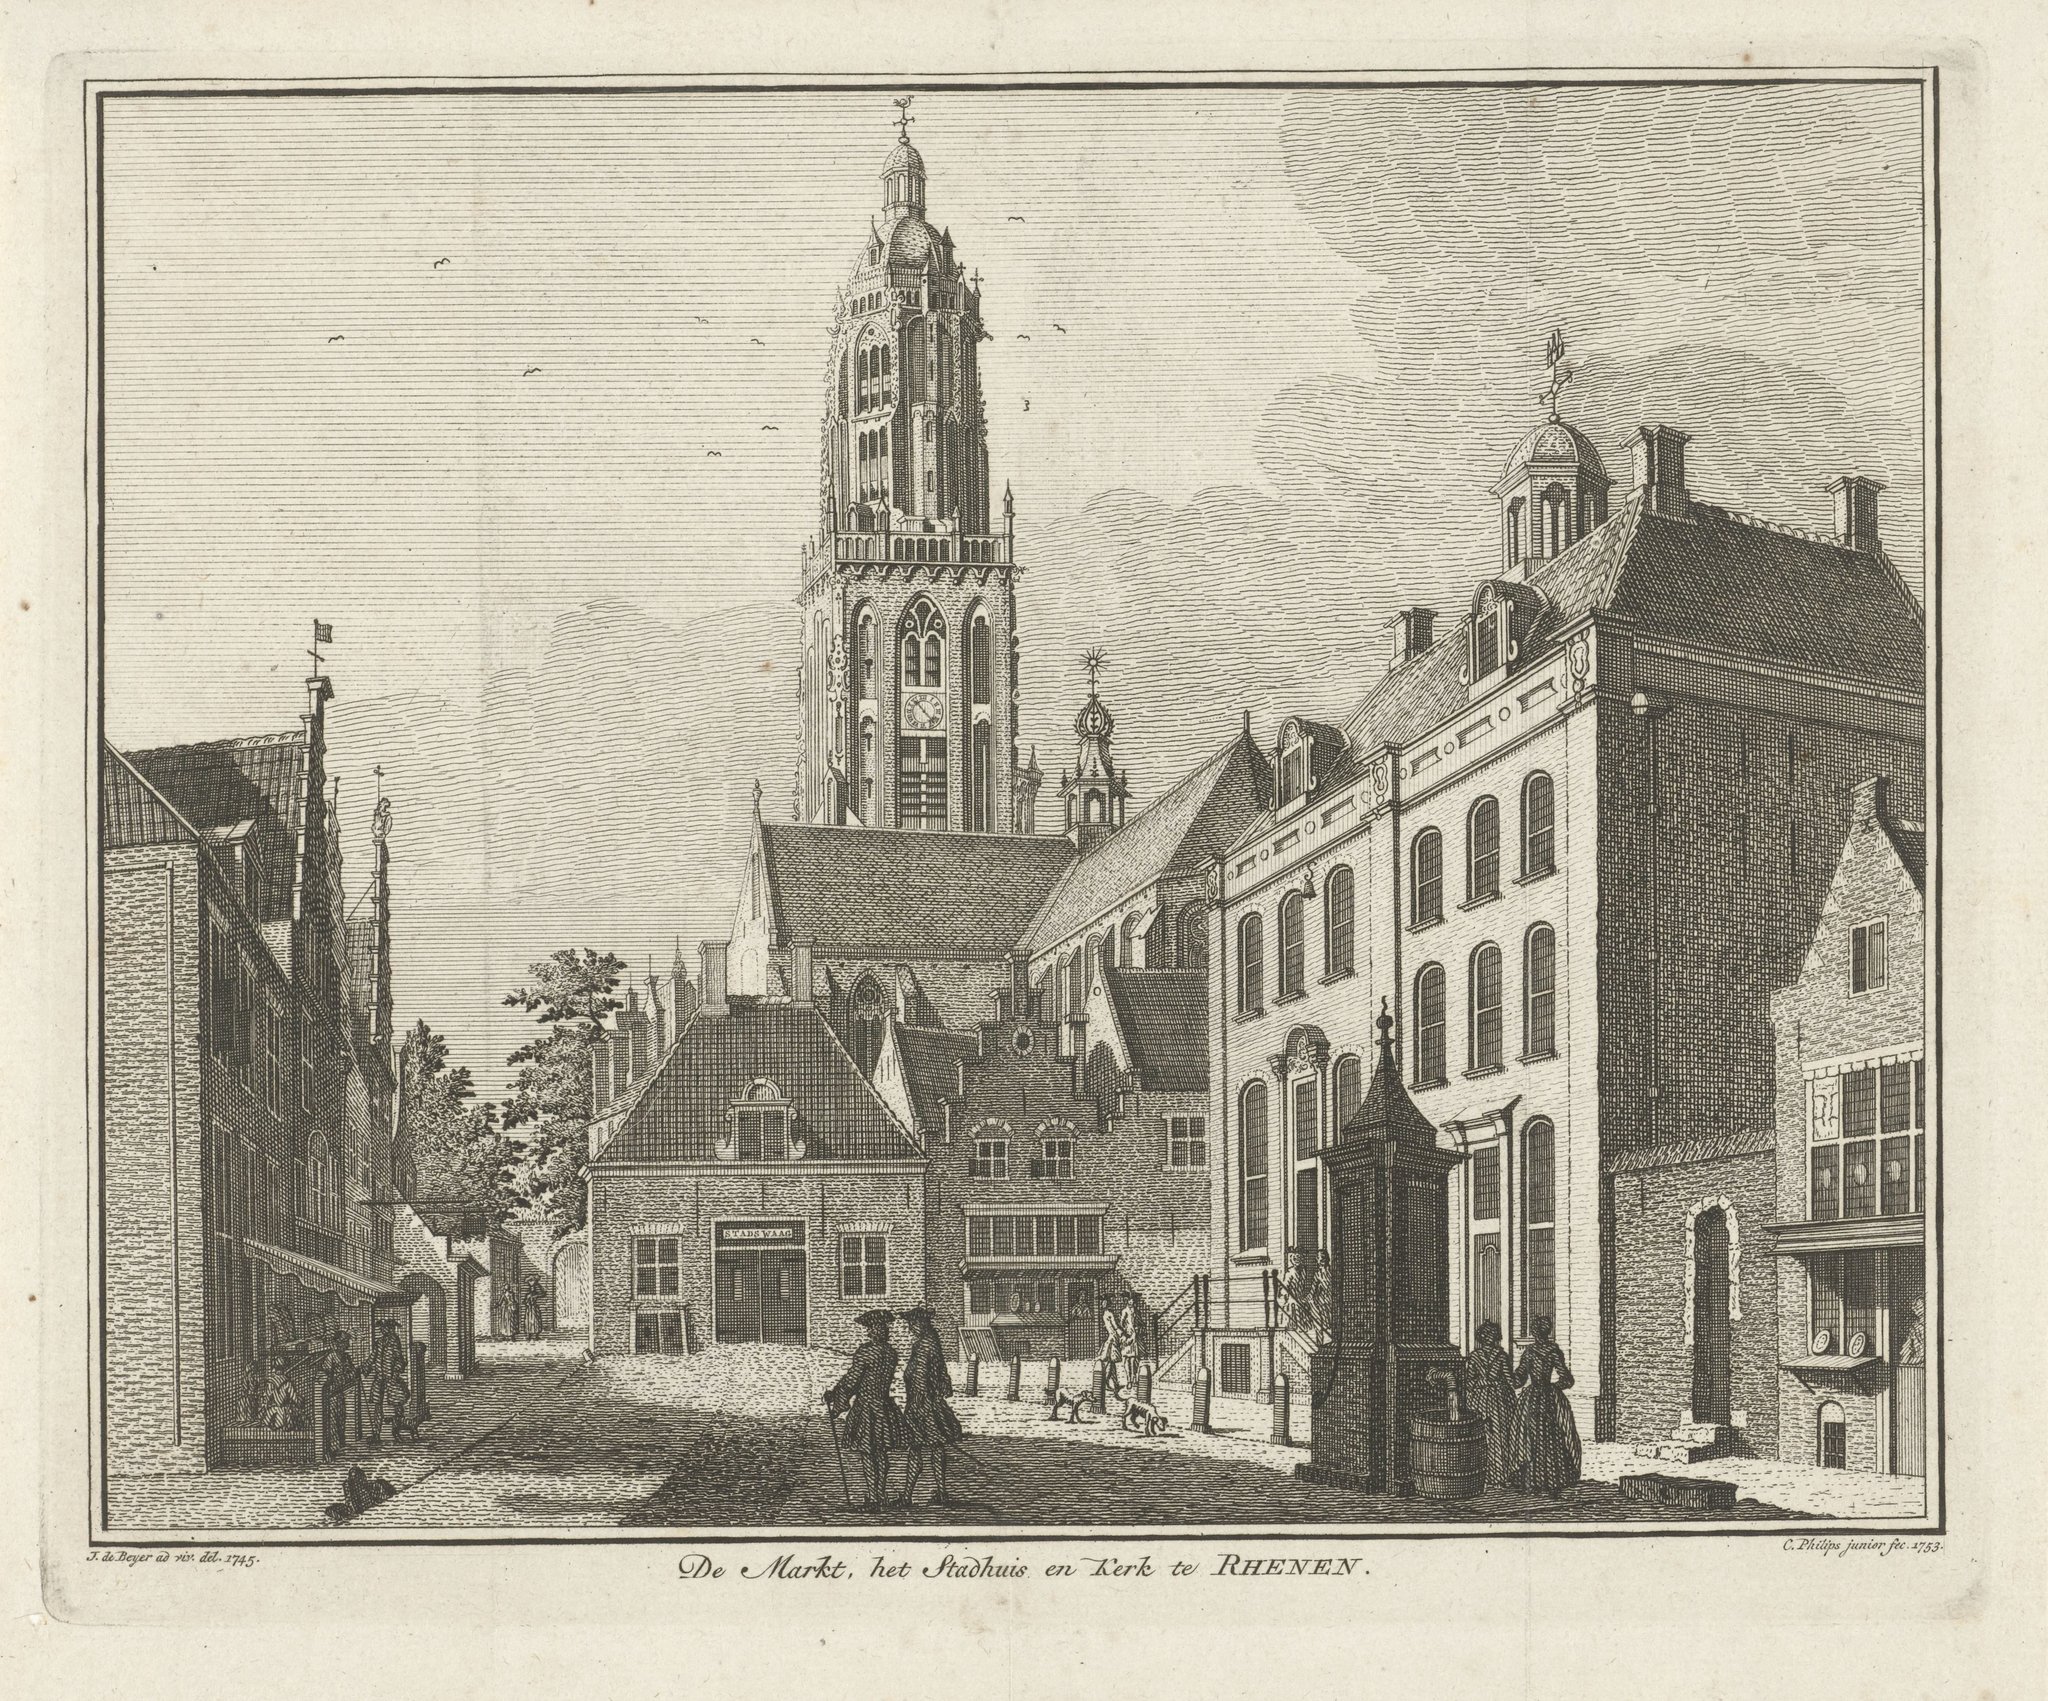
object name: print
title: De Markt, het Stadhuis en Kerk te Rhenen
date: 1753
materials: paper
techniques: etching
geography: amsterdam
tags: city-view in general; 'veduta', church (exterior), rhenen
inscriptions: collector's mark: Lugt 2228